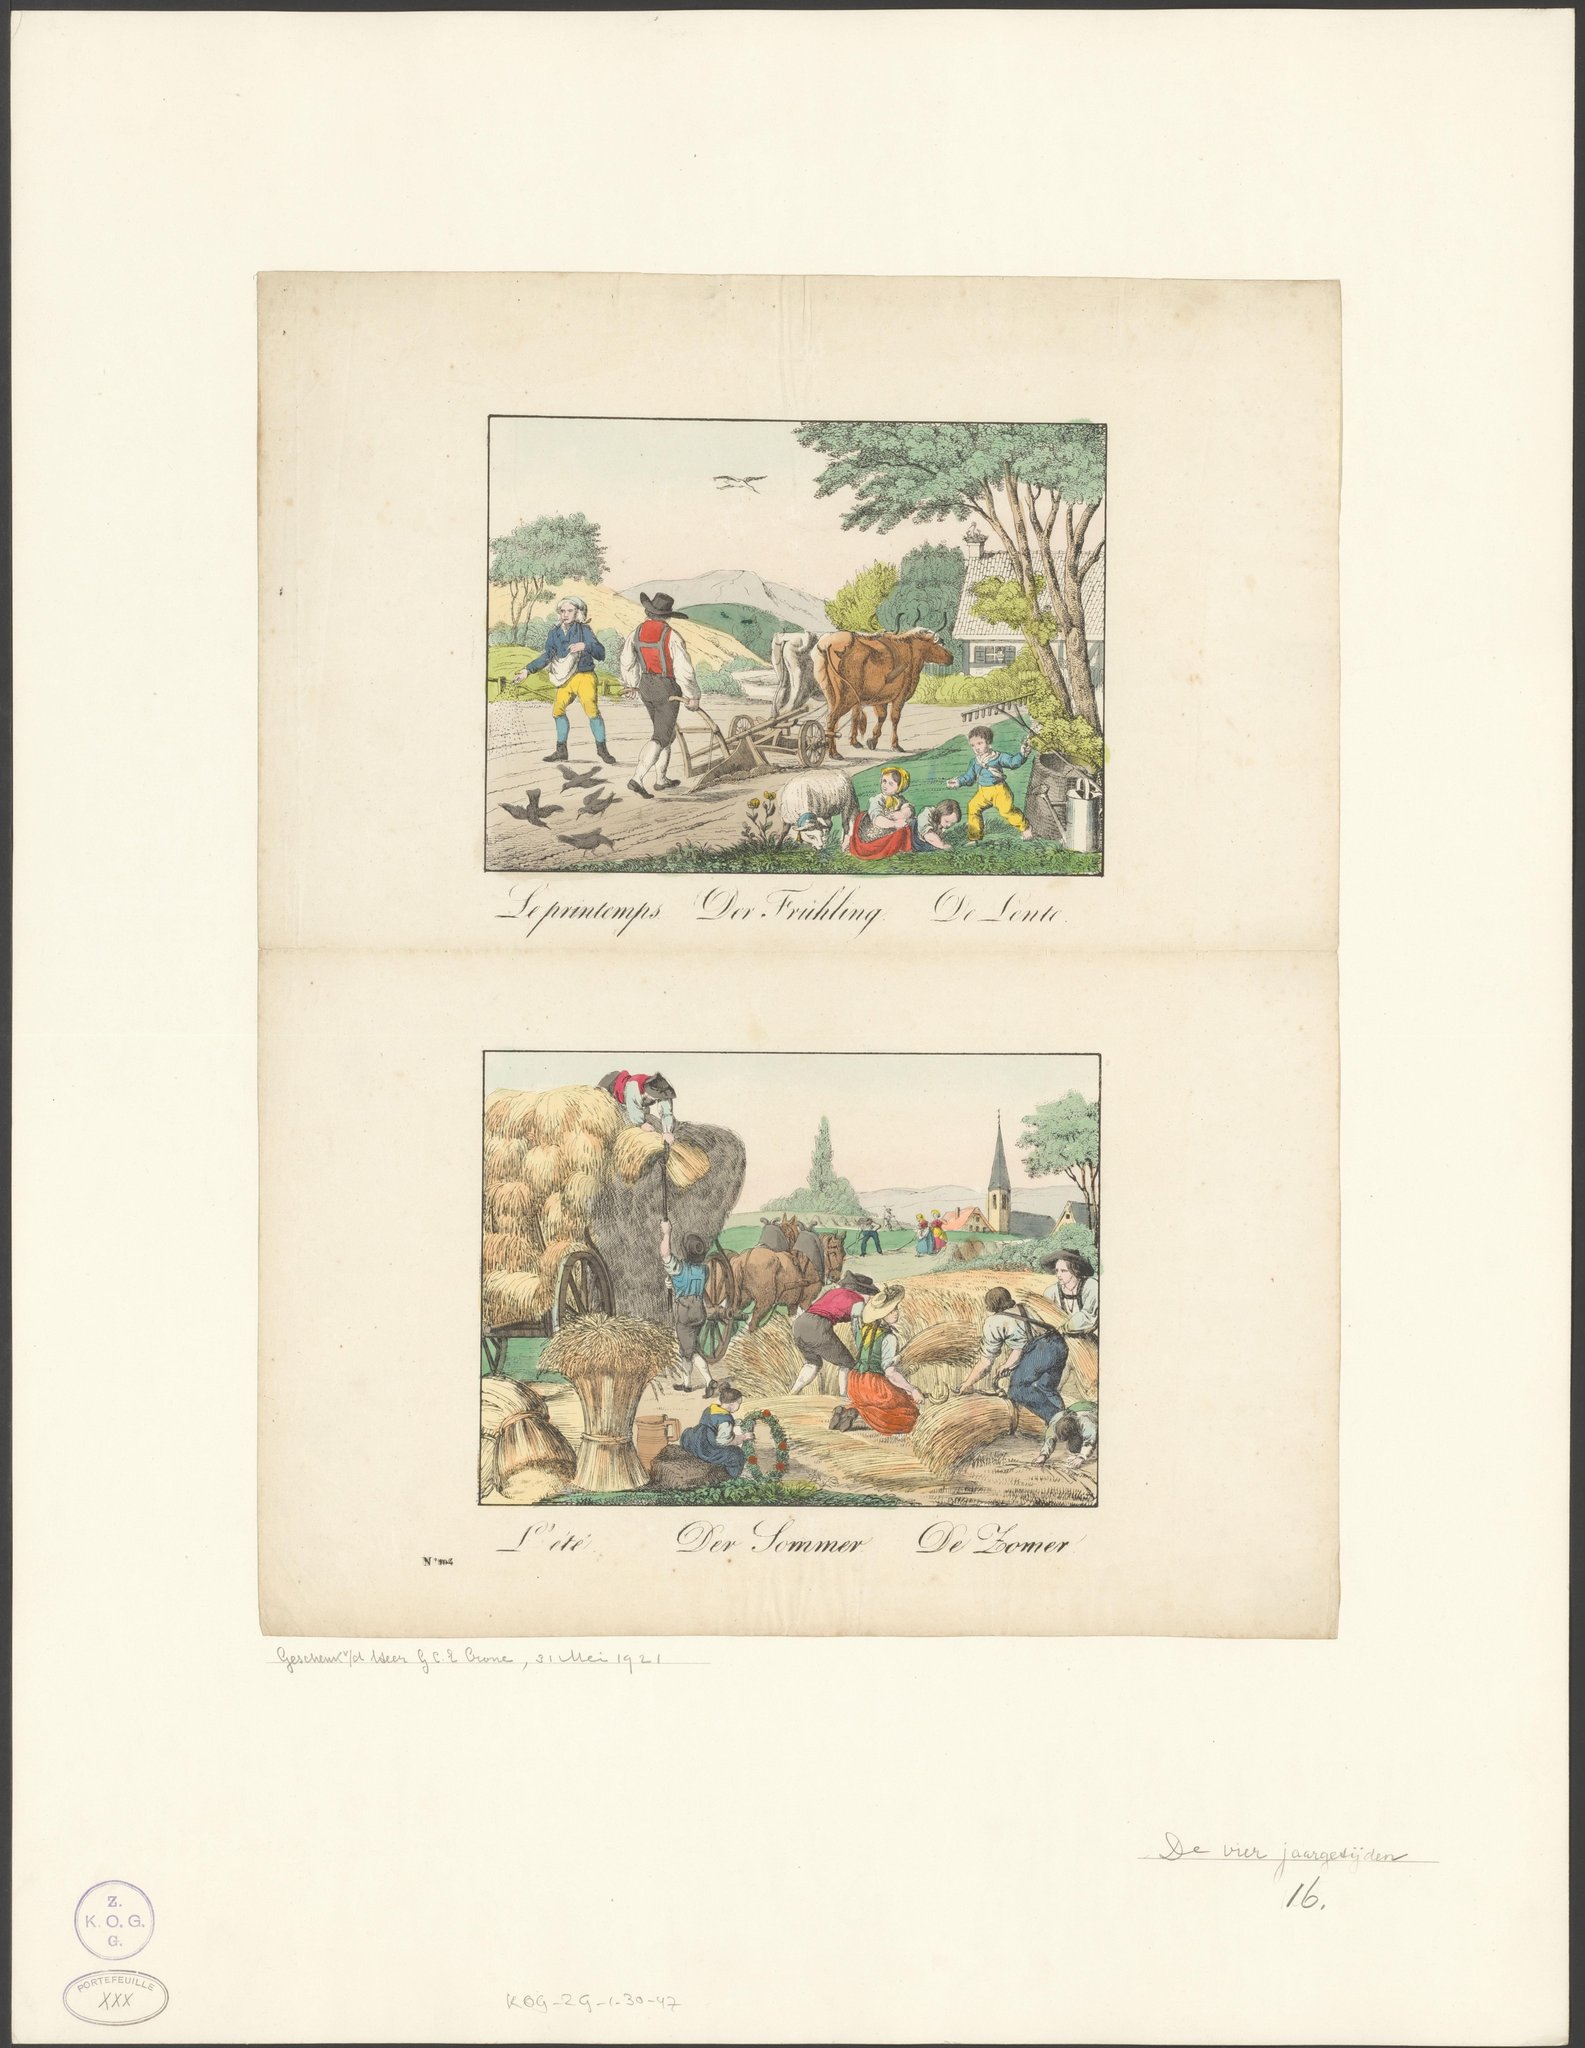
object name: print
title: Le printemps Der Fruhling De Lente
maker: Anonymous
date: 1800-1899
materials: paper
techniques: hand coloring, lithograph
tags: harvest, spring ~ human activities (the four seasons of the year), summer ~ human activities (the four seasons of the year), cereal, grain, corn (grass with grains, grown for food, e.g.: wheat, rice, rye, oats, maize, buckwheat, millet), agricultural implements: plough, ox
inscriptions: stamp, collector's mark: Lugt 1641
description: Linksonder genummerd: No 104. Onderwerpsrubrieken binnen de Atlas Zeden en Gewoonten: Zeden en Gewoonten in engeren zin. Volksleven. Zinnebeeldige voorstellingen uit het volkleven op serieprenten. Jaargetijden.